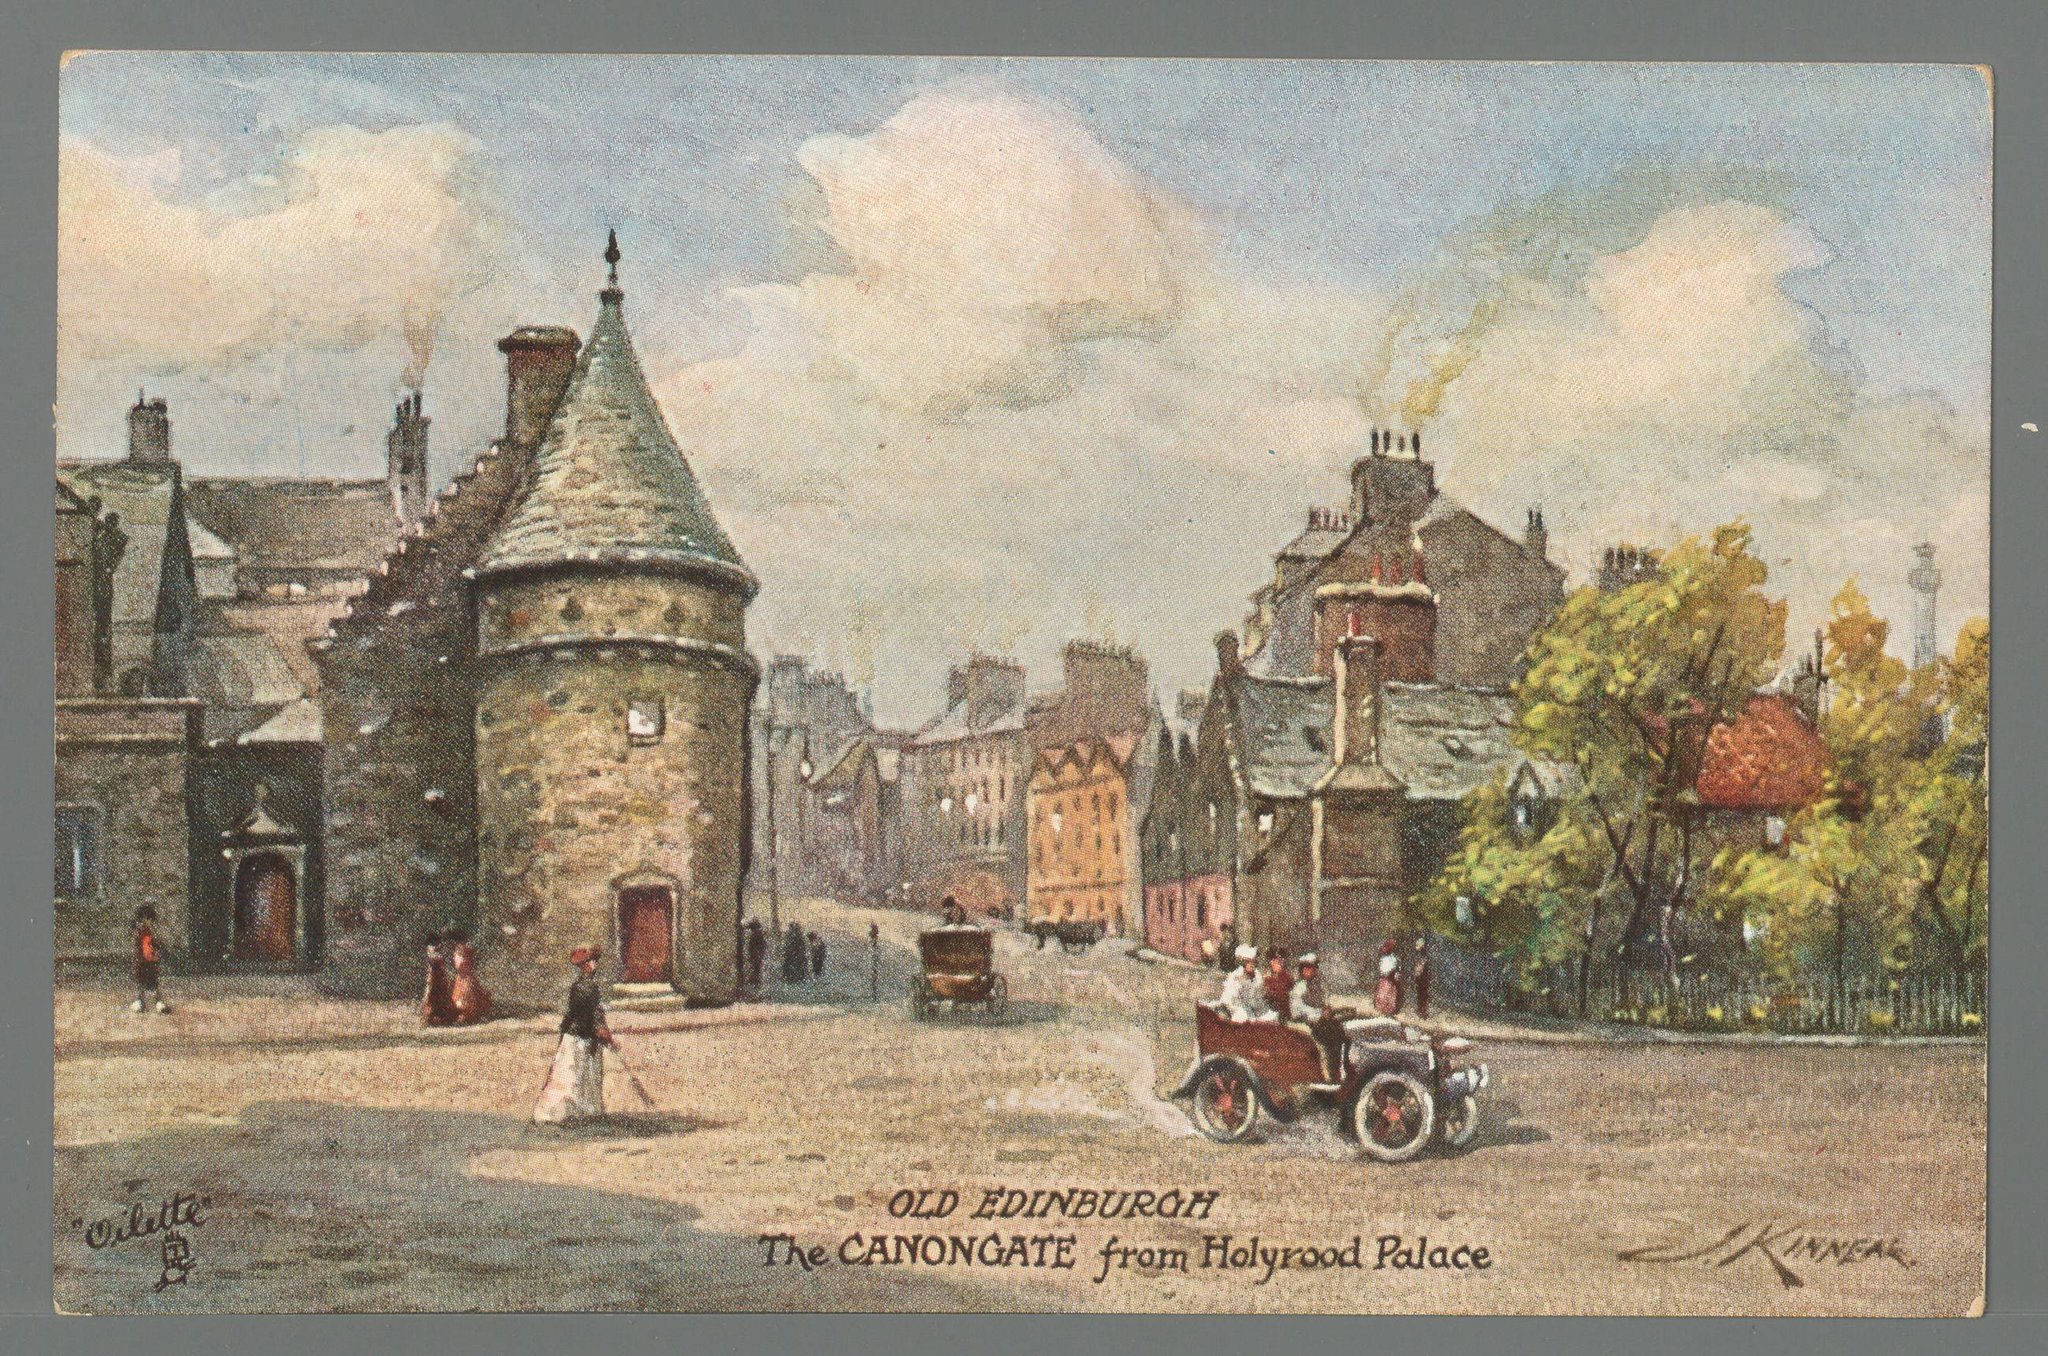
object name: photomechanical print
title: Old Edinburgh. Ser. II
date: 1911-1912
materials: cardboard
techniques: color autotype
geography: bavaria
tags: automobile, street